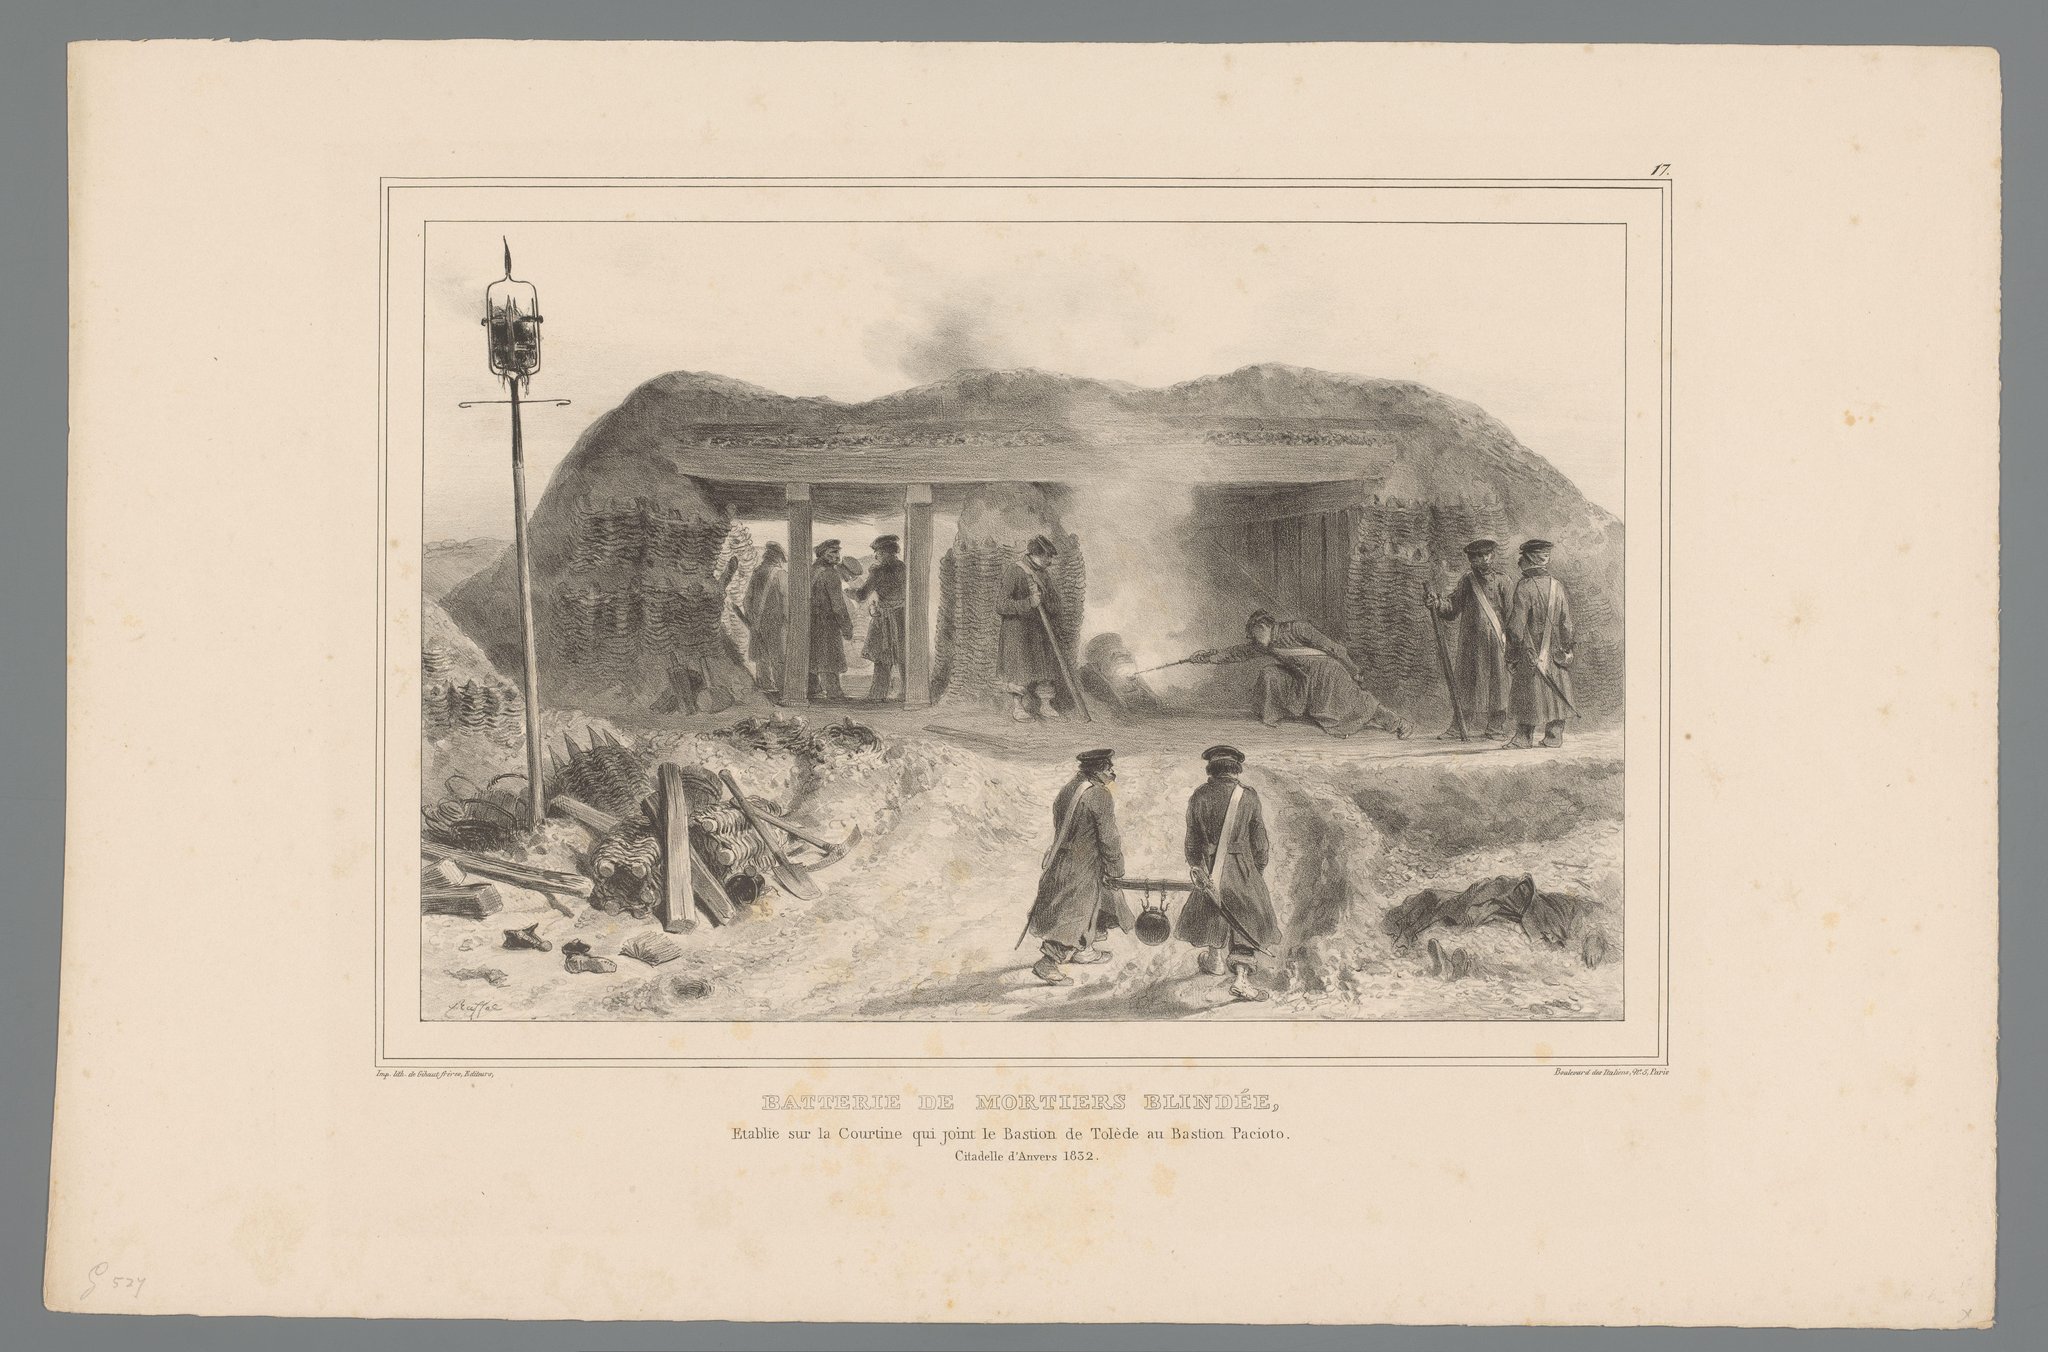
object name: print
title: Beleg van de Citadel van Antwerpen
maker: denis auguste marie raffet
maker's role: draughtsman, print maker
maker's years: 1804-1860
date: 1833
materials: paper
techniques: lithograph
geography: france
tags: firearms (with name), siege, position war, the soldier; the soldier's life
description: Soldaat bezig met het afschieten van een mortier in een ingegraven stelling. Onderdeel van de serie van 24 prenten over het beleg van de Citadel van Antwerpen, 30 november - 23 december 1832.